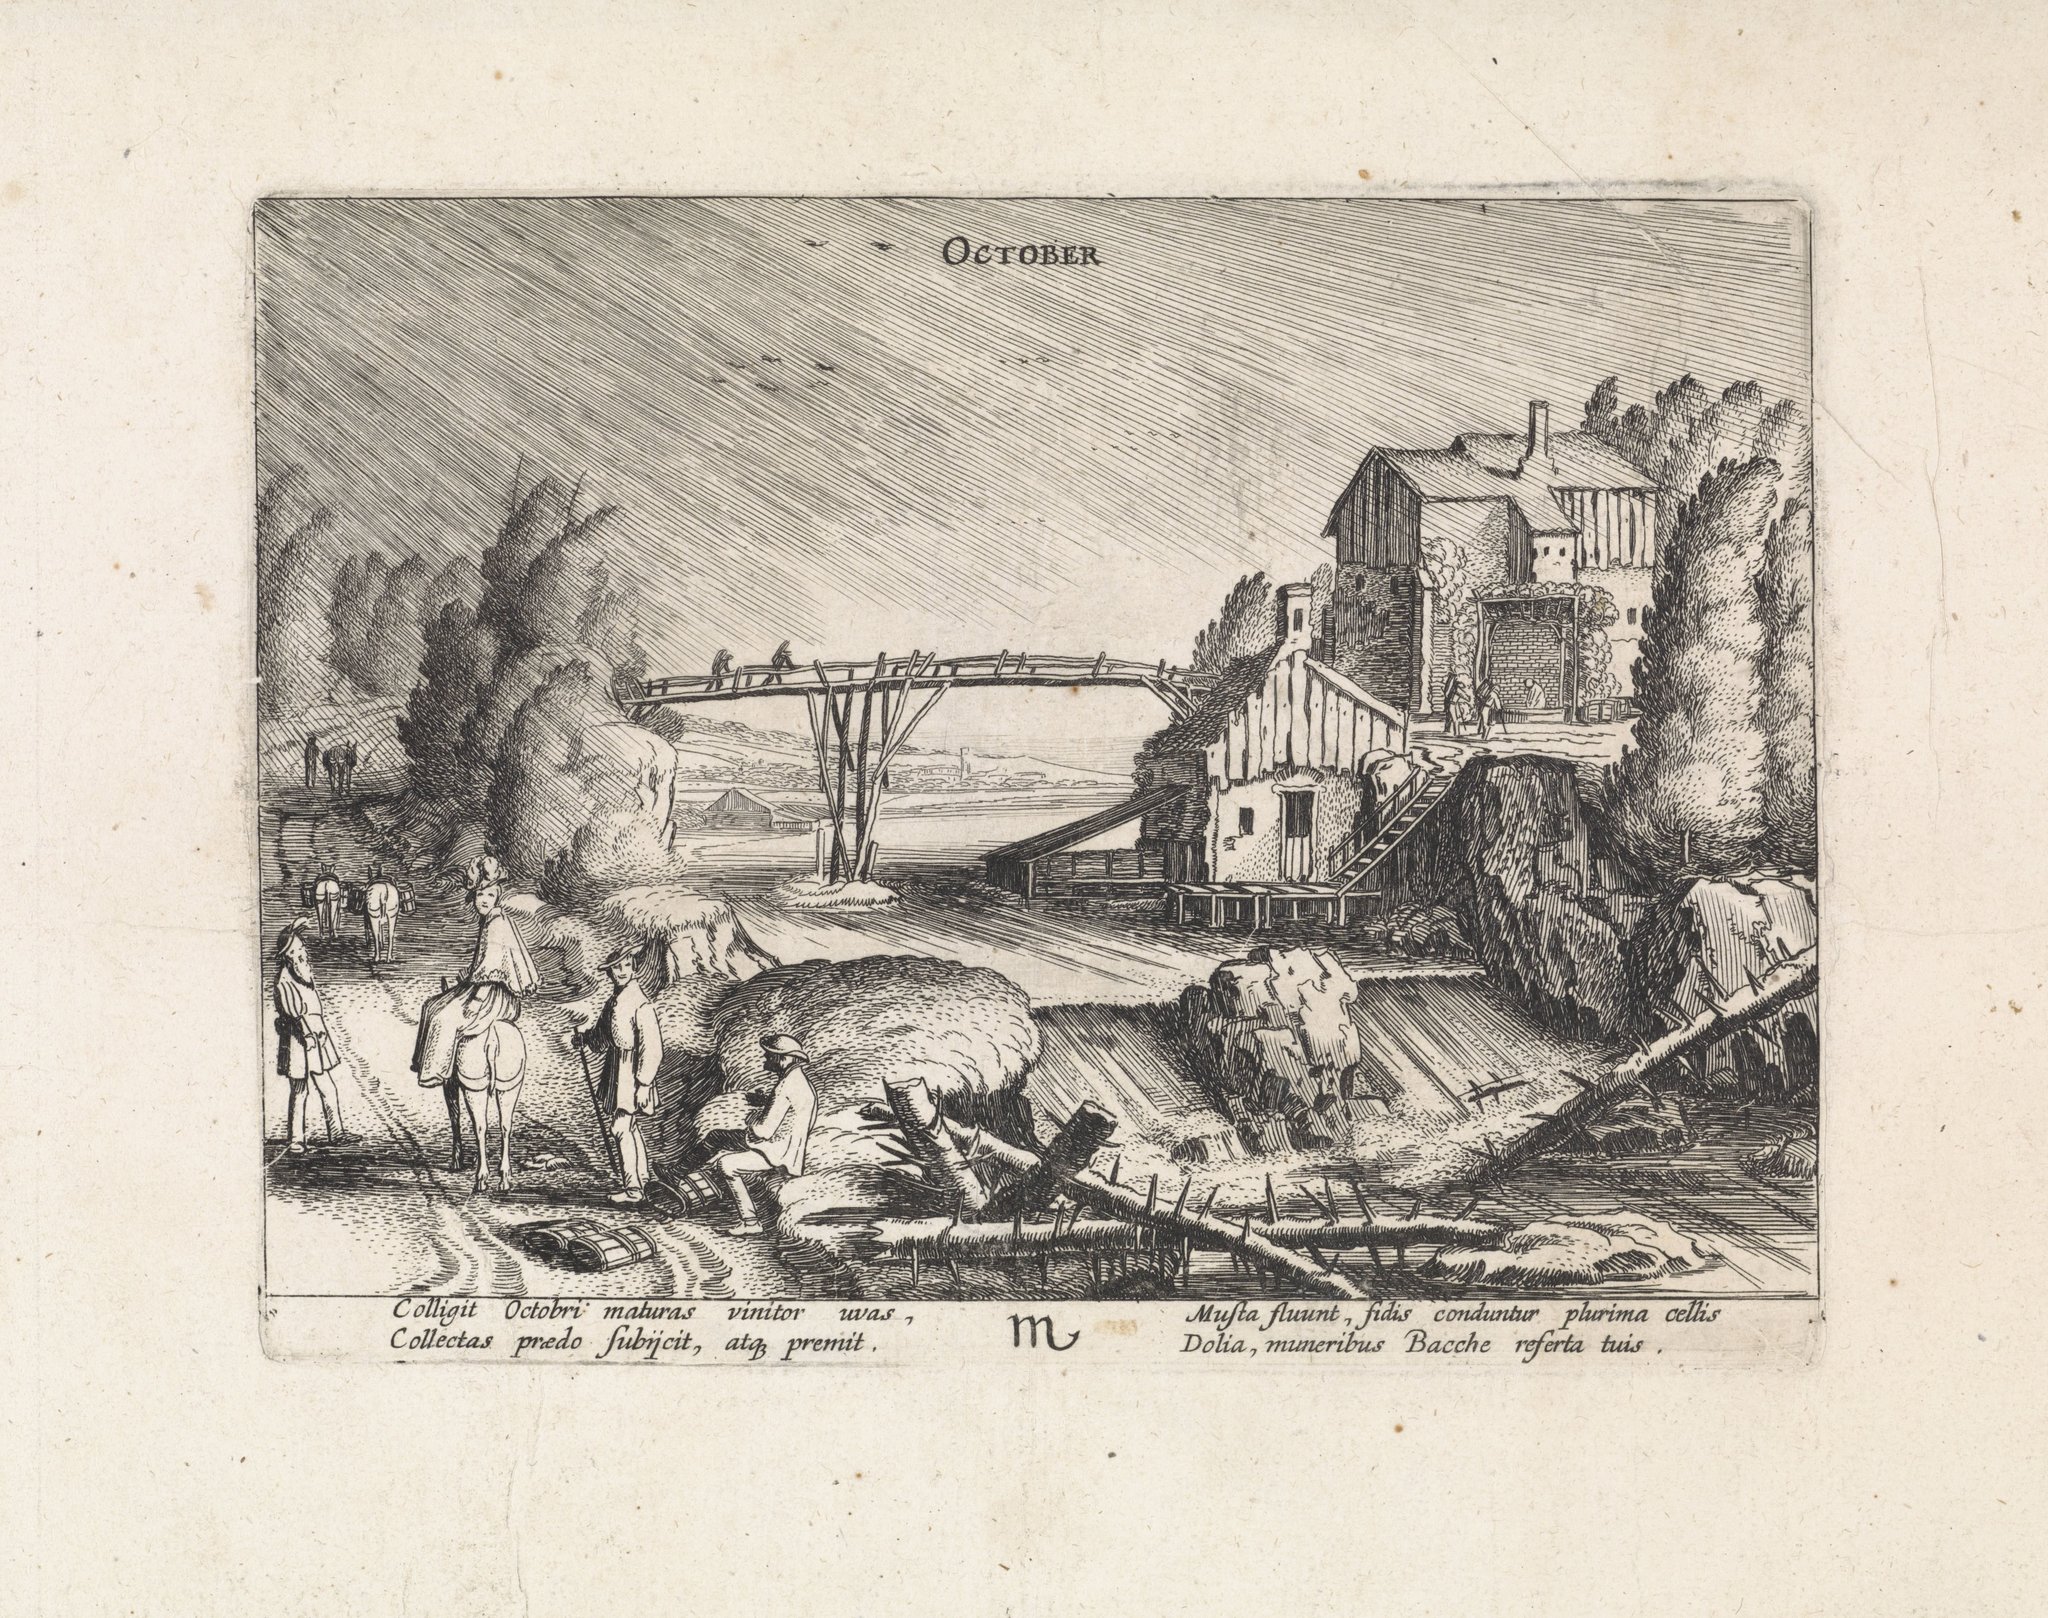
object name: print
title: October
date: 1608-1618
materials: paper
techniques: engraving, etching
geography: northern netherlands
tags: landscape symbolizing october, river, landscape with bridge, viaduct or aqueduct, scorpio (zodiacal sign of october), rain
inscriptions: collector's mark: Lugt 964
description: Een rivierlandschap met figuren op een landweg in de regen, voorstellende de maand oktober. In het midden een houten brug. Rechts een huis met een man in een wijnkuip. Onderaan het astrologische symbool van het sterrenbeeld schorpioen. Prent uit een serie van twaalf.